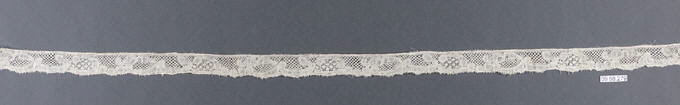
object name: border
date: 1701-1800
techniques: lace